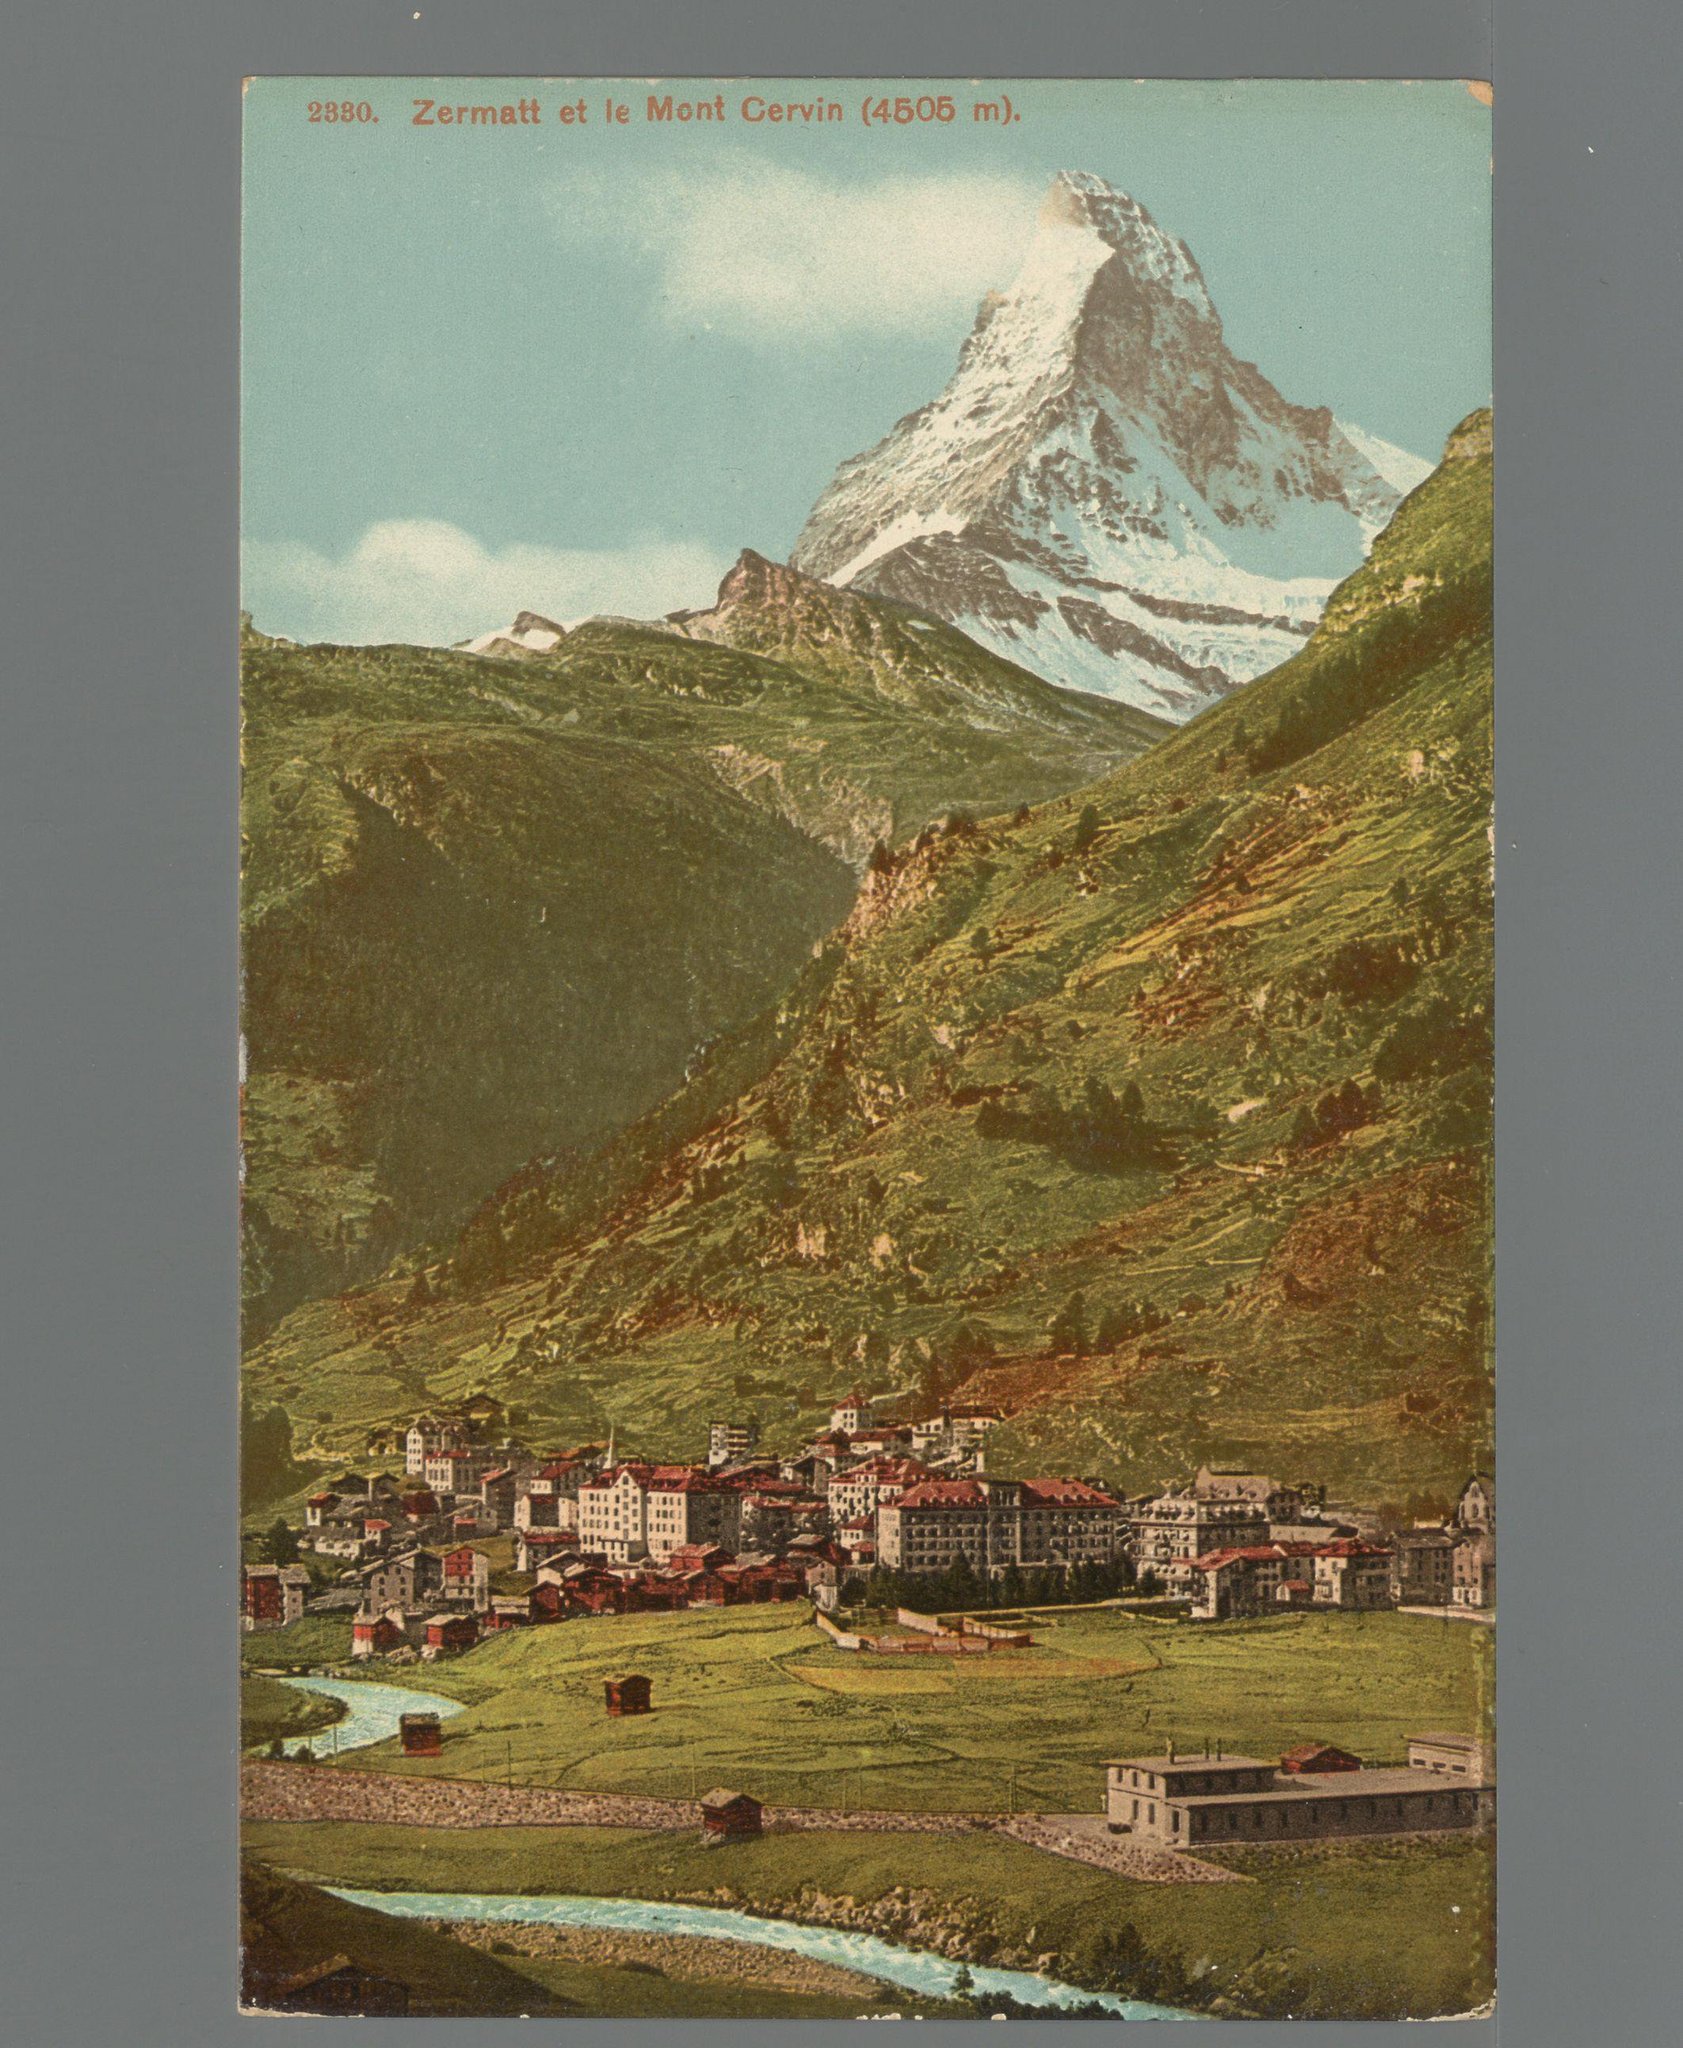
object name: photomechanical print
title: Zermatt et le Mont Cervin (4505 m)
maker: Anonymous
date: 1903-1904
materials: cardboard, photographic process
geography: zurich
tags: prospect of village, silhouette of village, mountain-range, snow peaks